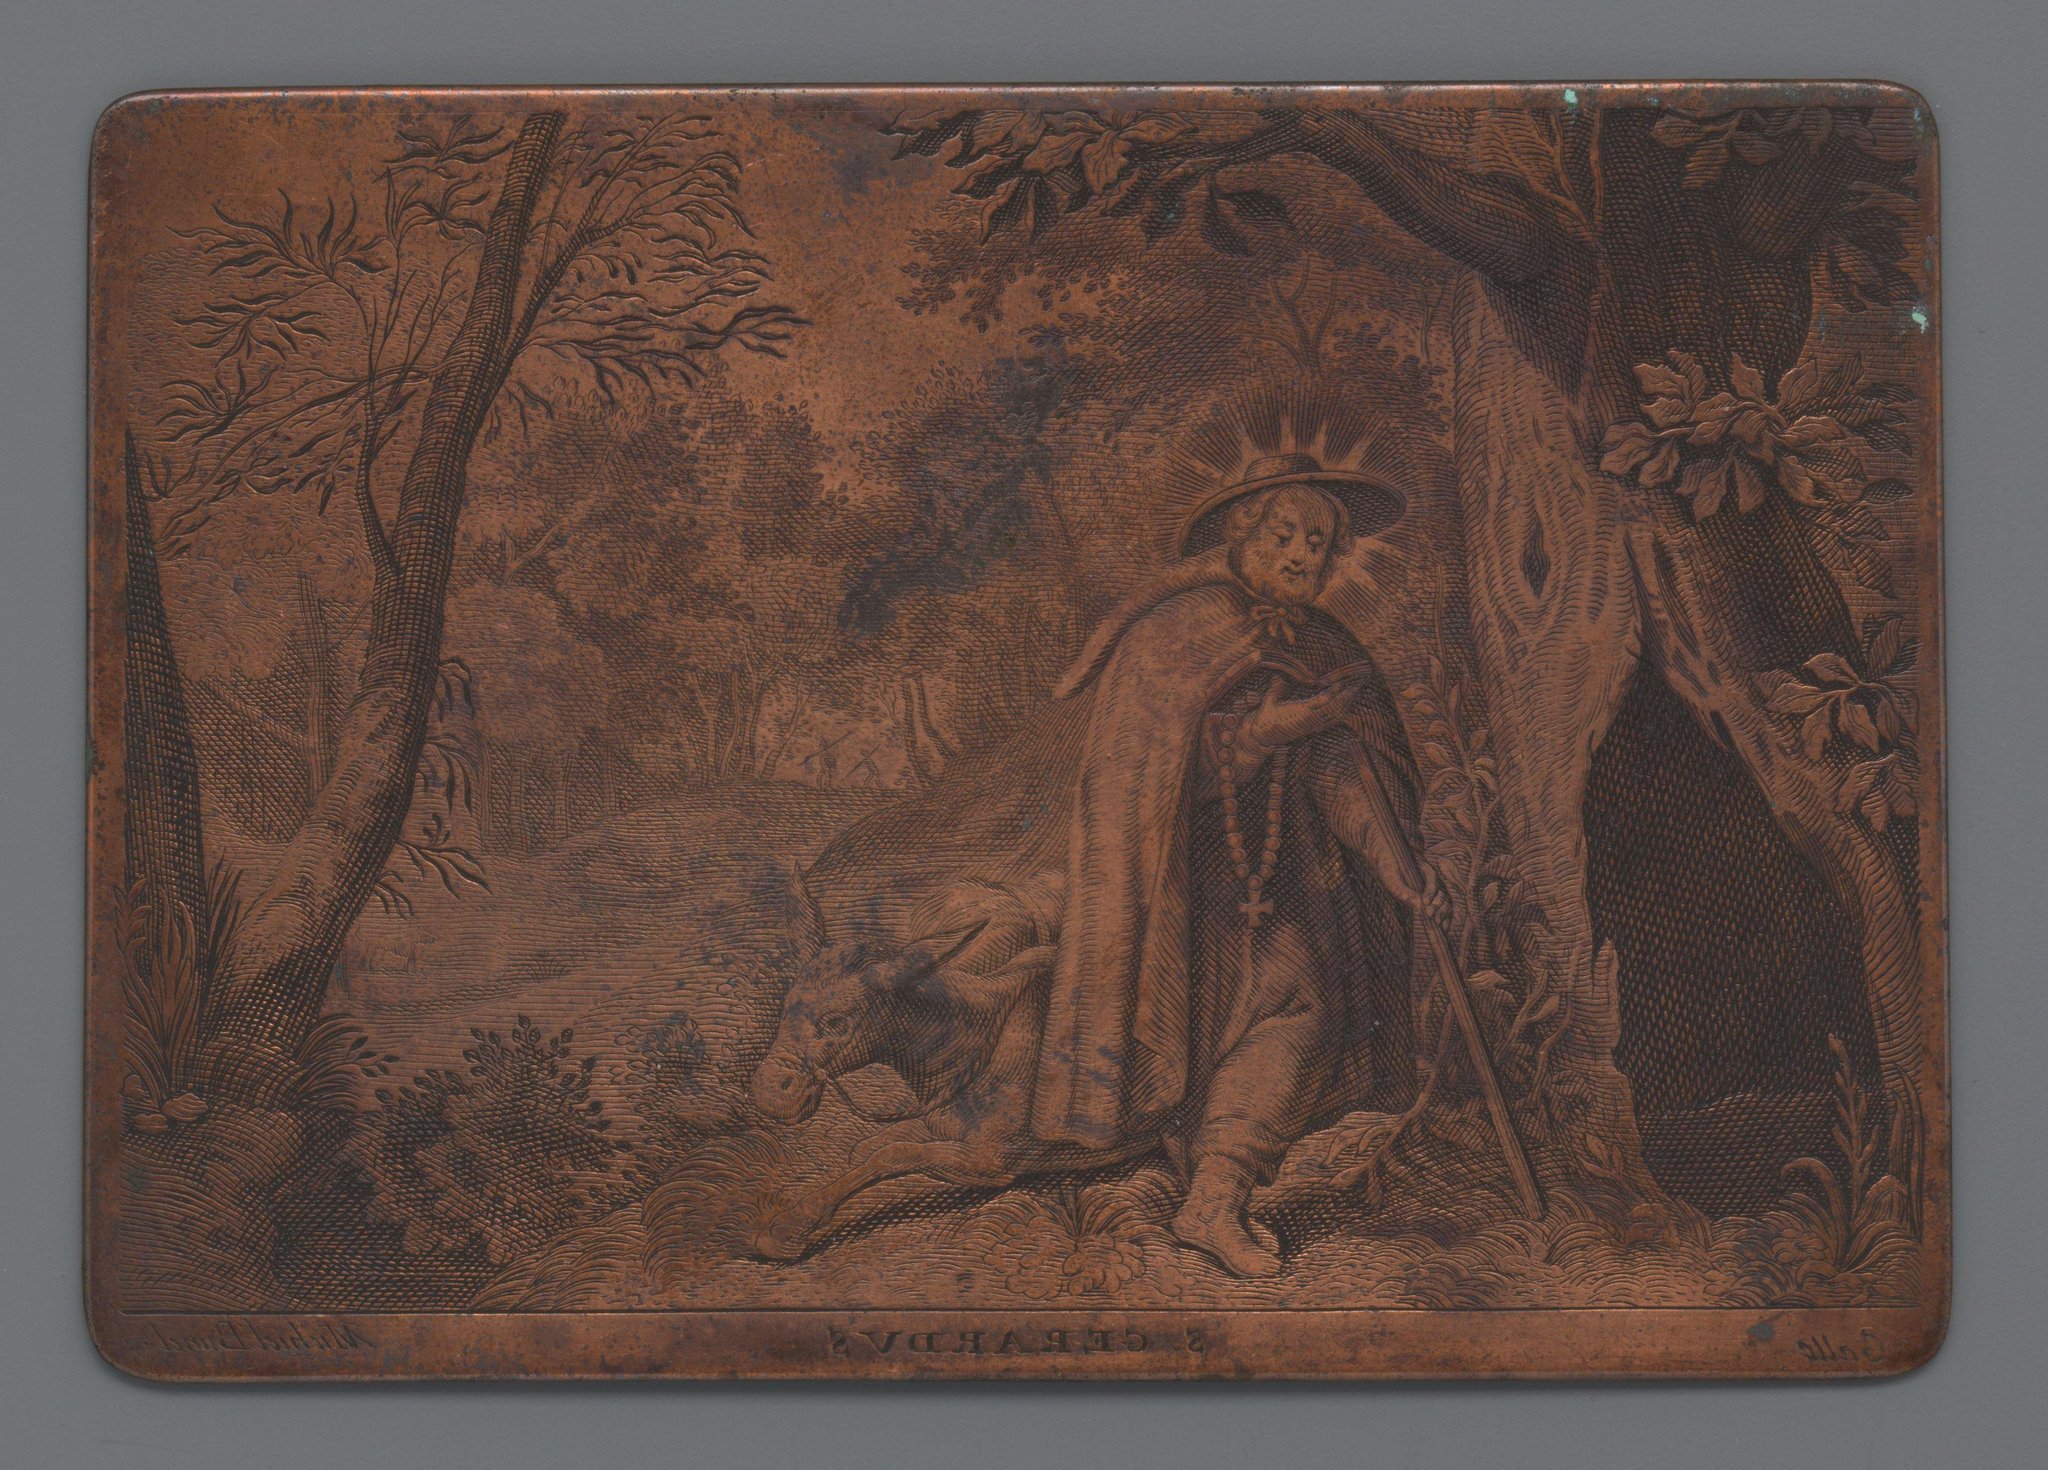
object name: copper plate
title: Koperplaat met de Heilige Geraldus van Mitternach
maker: michel bunel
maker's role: print maker, publisher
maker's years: 1670-1739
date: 1680-1739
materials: copper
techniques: engraving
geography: antwerp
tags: male saints (with name)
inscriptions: signature: ‘Michiel Bunel Galle’, : ‘Saint Gerardus’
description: De platen (RP-D-2014-9-1 t/m 35) zijn vrijwel allemaal vervaardigd door anonieme graveurs werkend voor de Antwerpse uitgevers Cornelis Galle, Frans Huberti (Huybrechts), Theodor van Merlen II en Michel Bunel. Vermoedelijk zijn ze uiteindelijk beland in één fonds, wellicht dat van Michel Bunel (1670-1739) en warden sindsdien bij elkaar bewaard. Afwijkend is de grote prent van Henry Verbruggen met een weergave van de Preekstoel uit de St. Gudule-kerk te Brussel. Twee prenten zijn verpakt in een oude afdruk van de prent, zoals te doen gebruikelijk in uitgeverijen (vergl. oude platen in Museum Plantijn Moretus, Antwerpen). Van 8 platen heeft de vorige eigenaar afdrukken laten maken op modern papier.